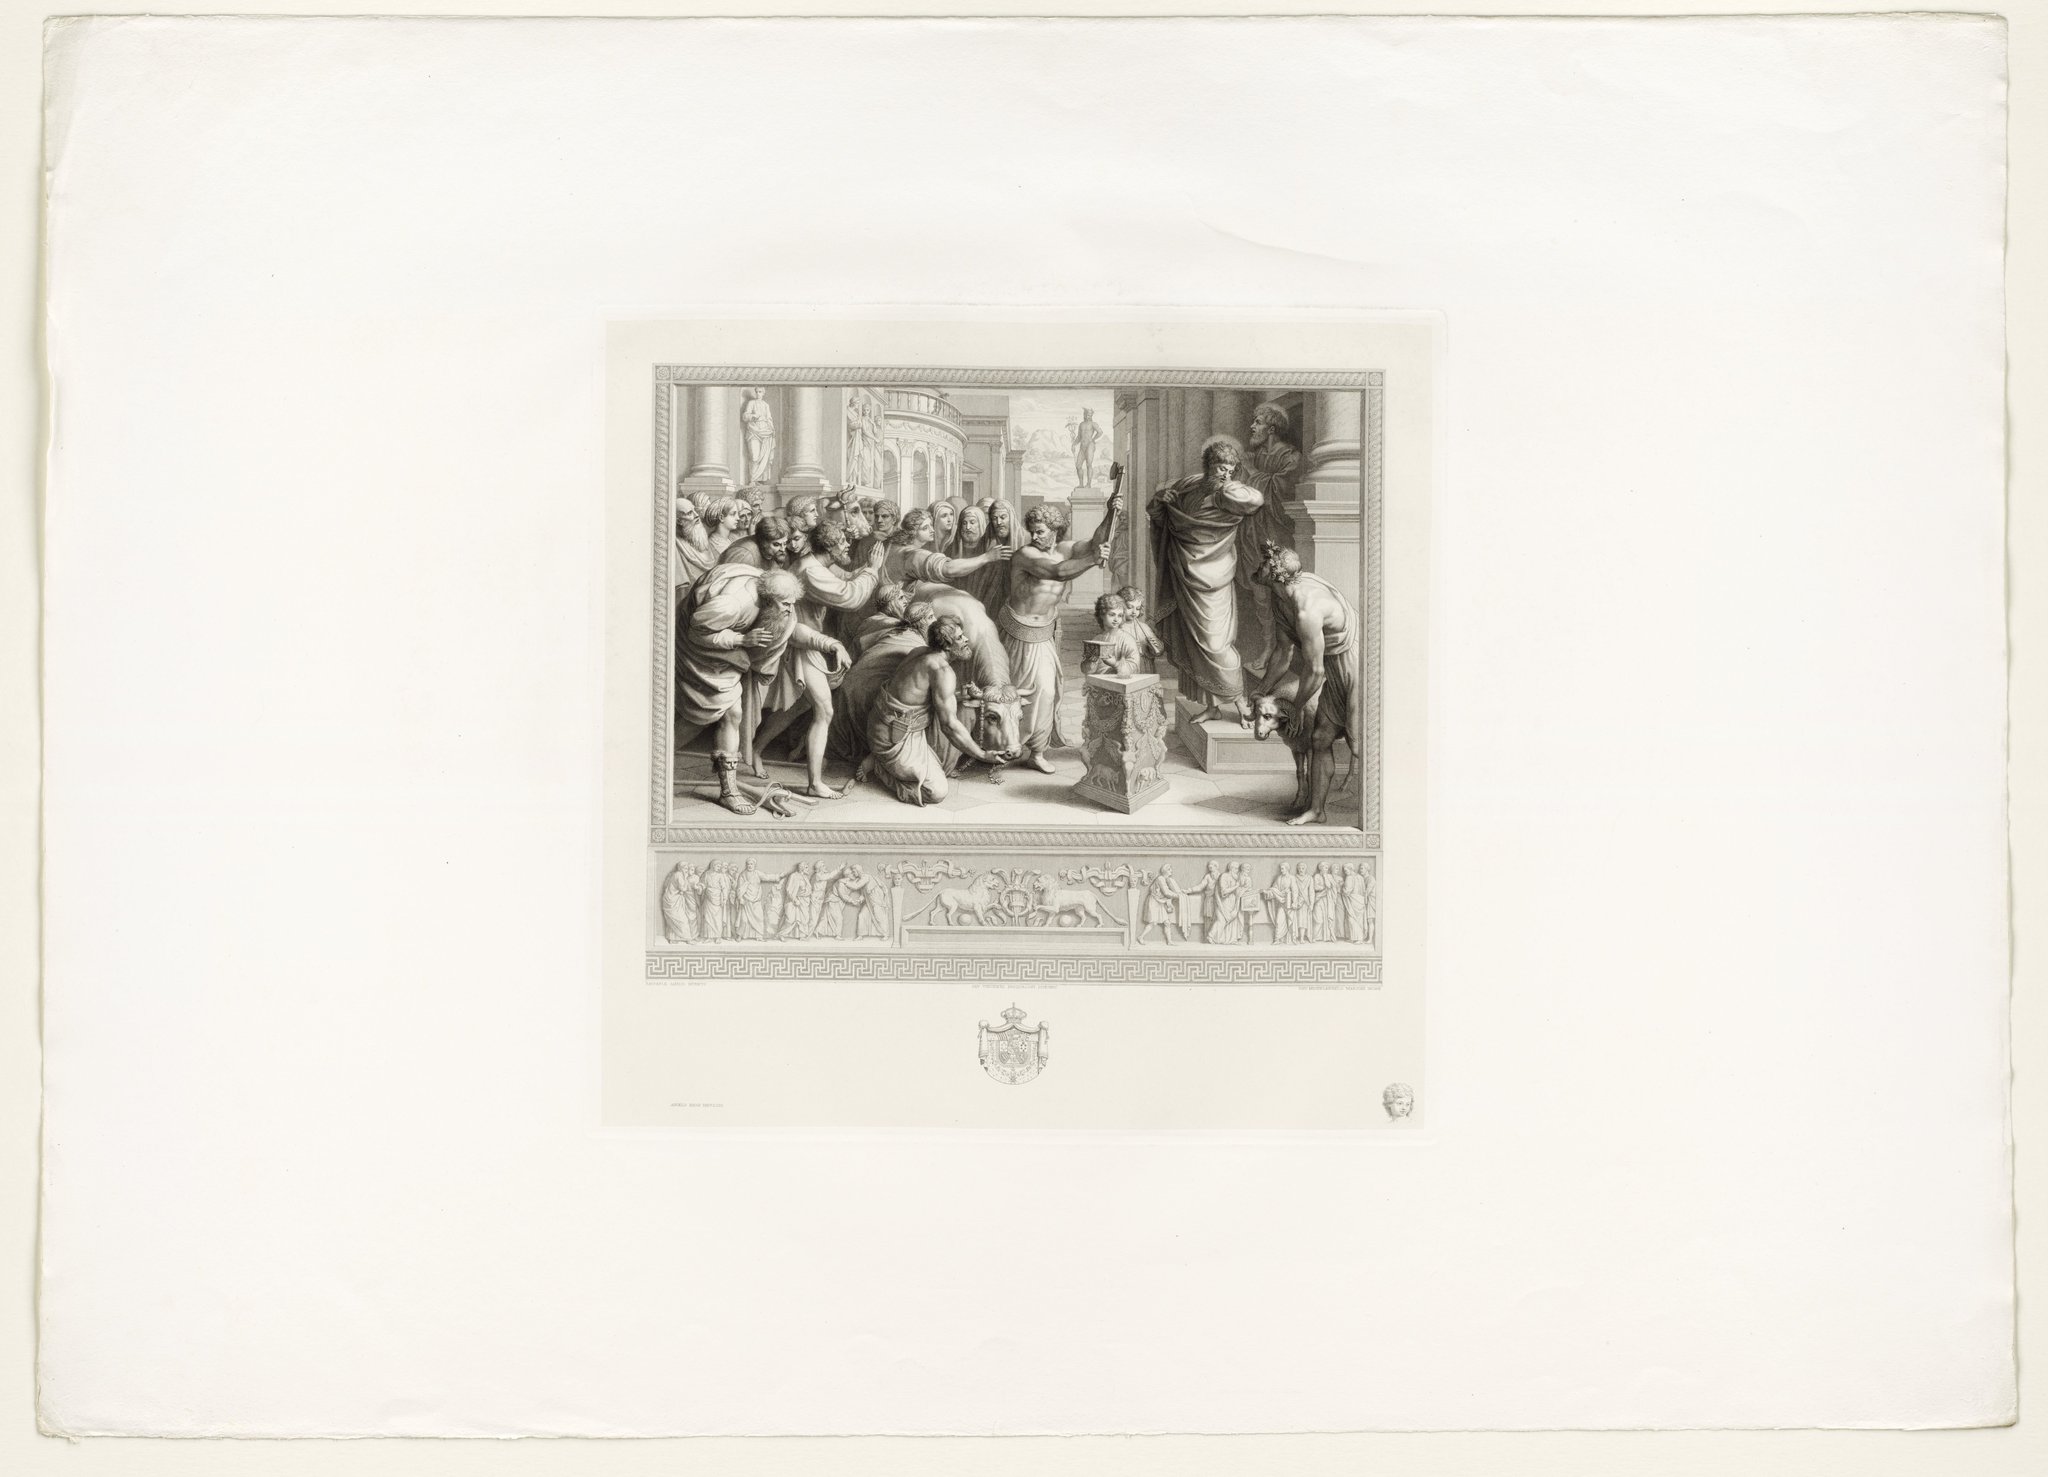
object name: print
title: Offer van een stier, naar Raphaël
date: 1816-1882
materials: paper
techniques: engraving, etching